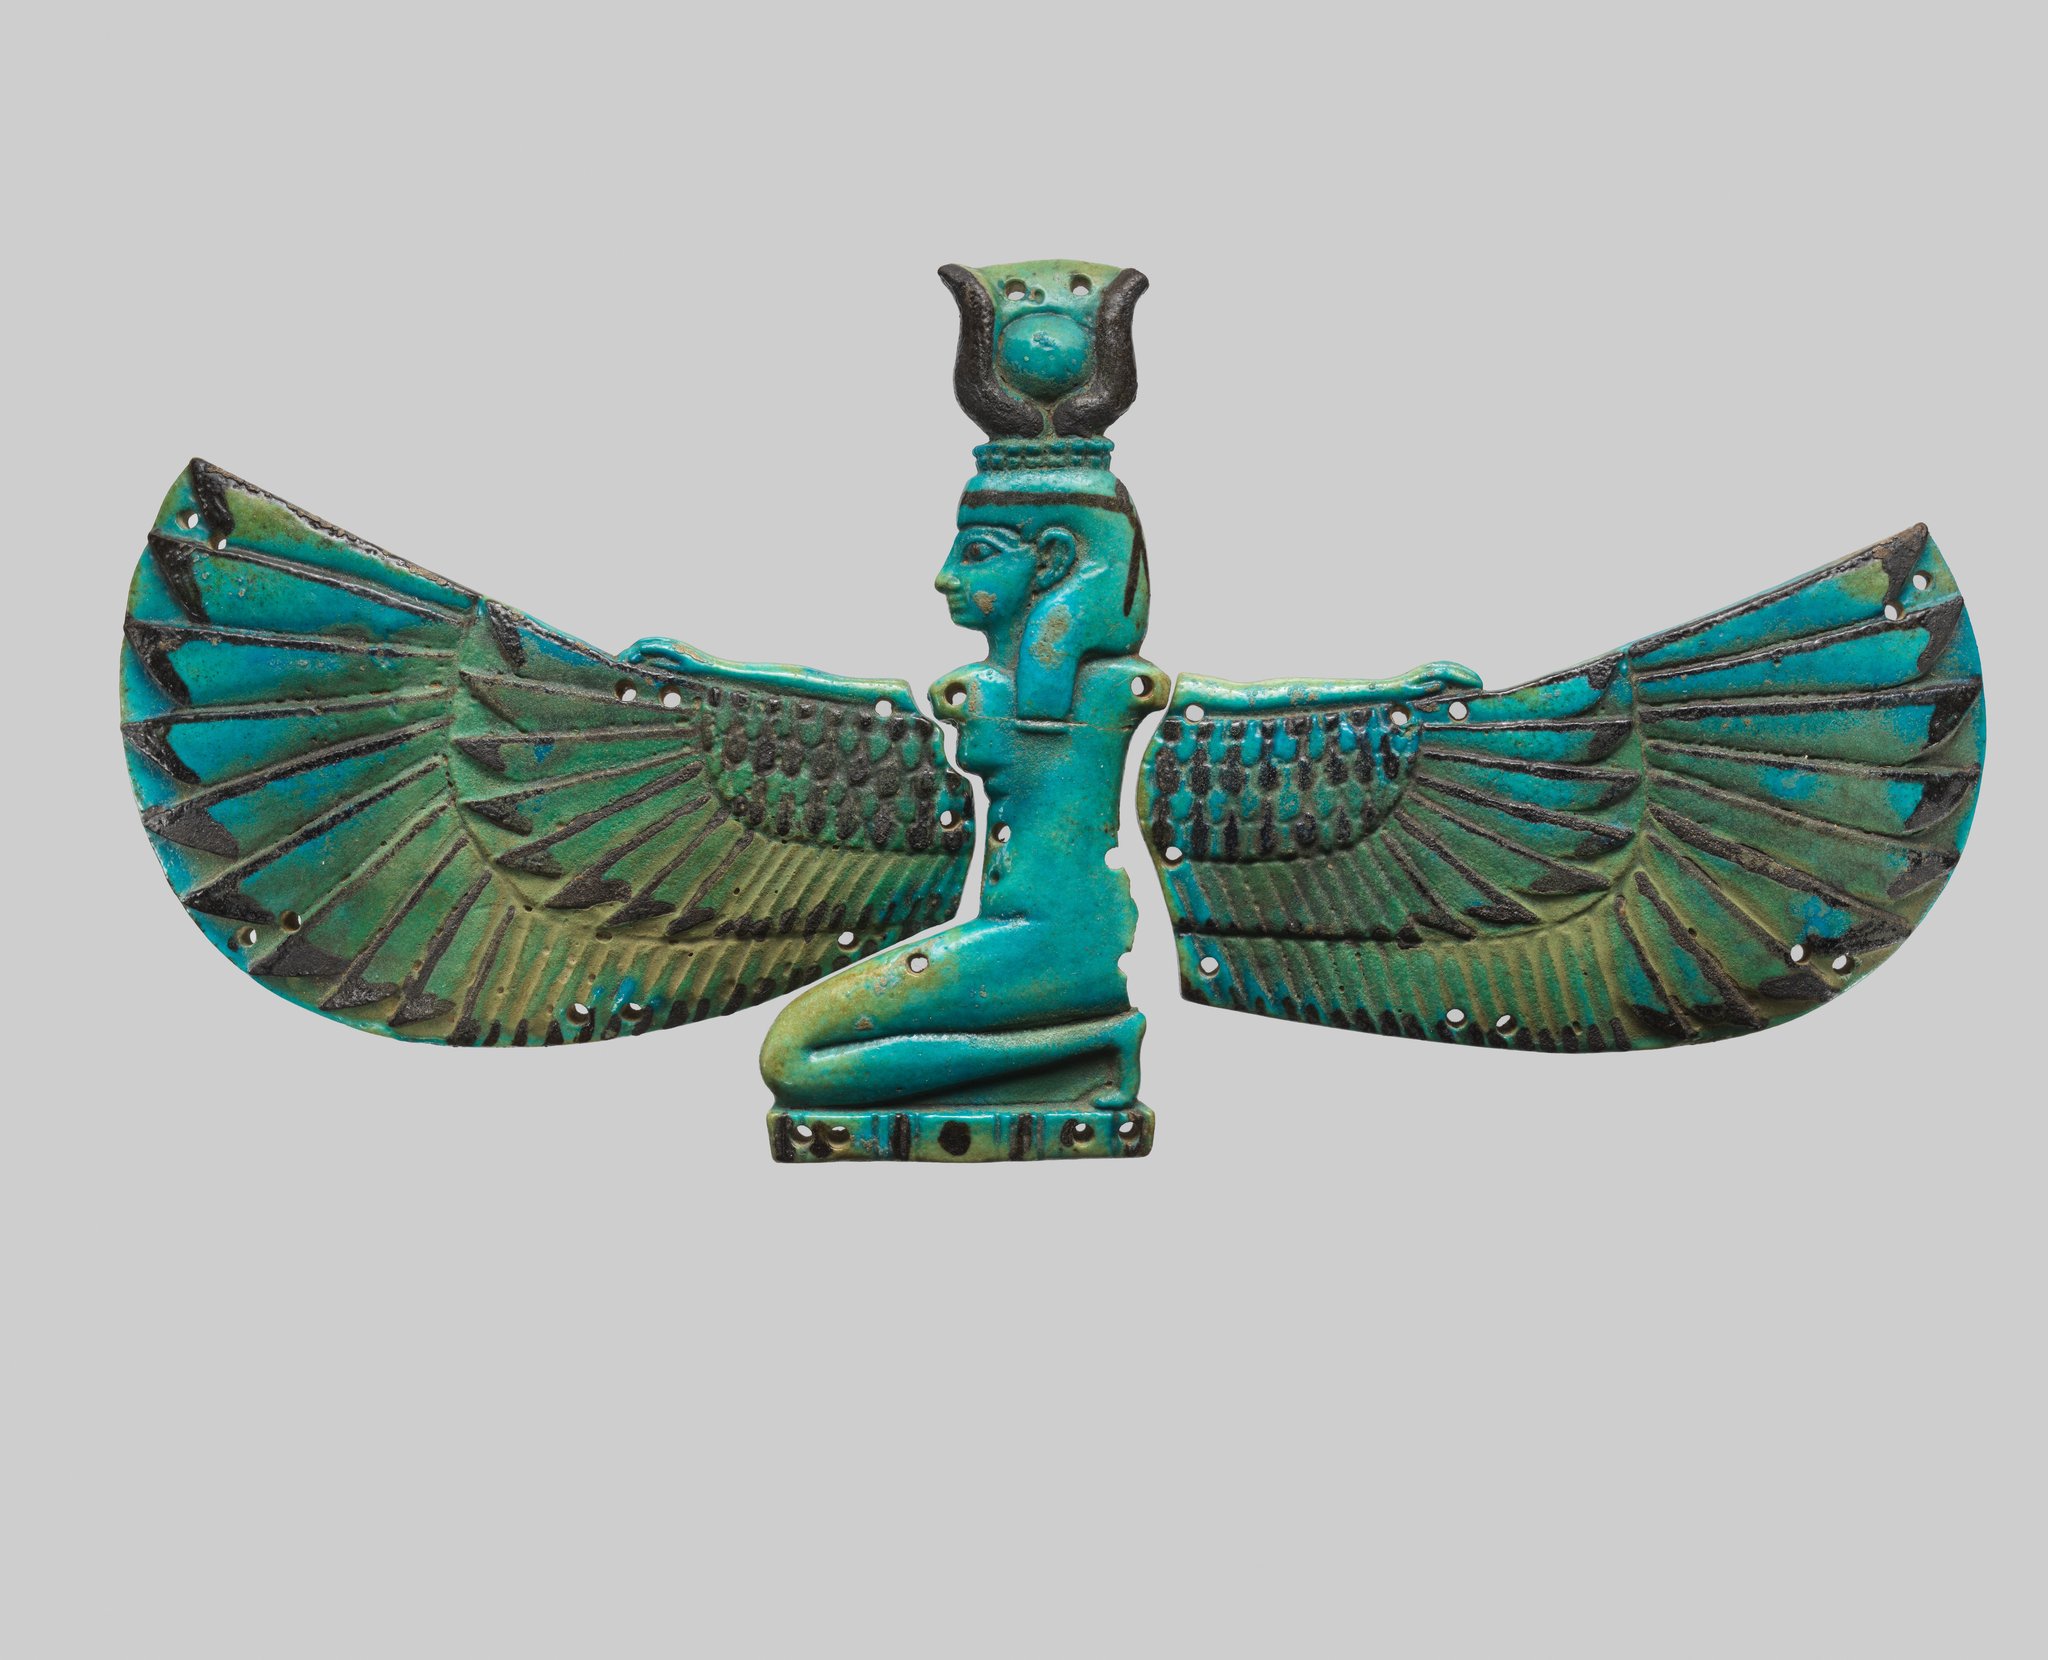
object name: winged goddess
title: Winged Goddess, probably Nut or Isis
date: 1070-332 BCE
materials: faience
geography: egypt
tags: goddess